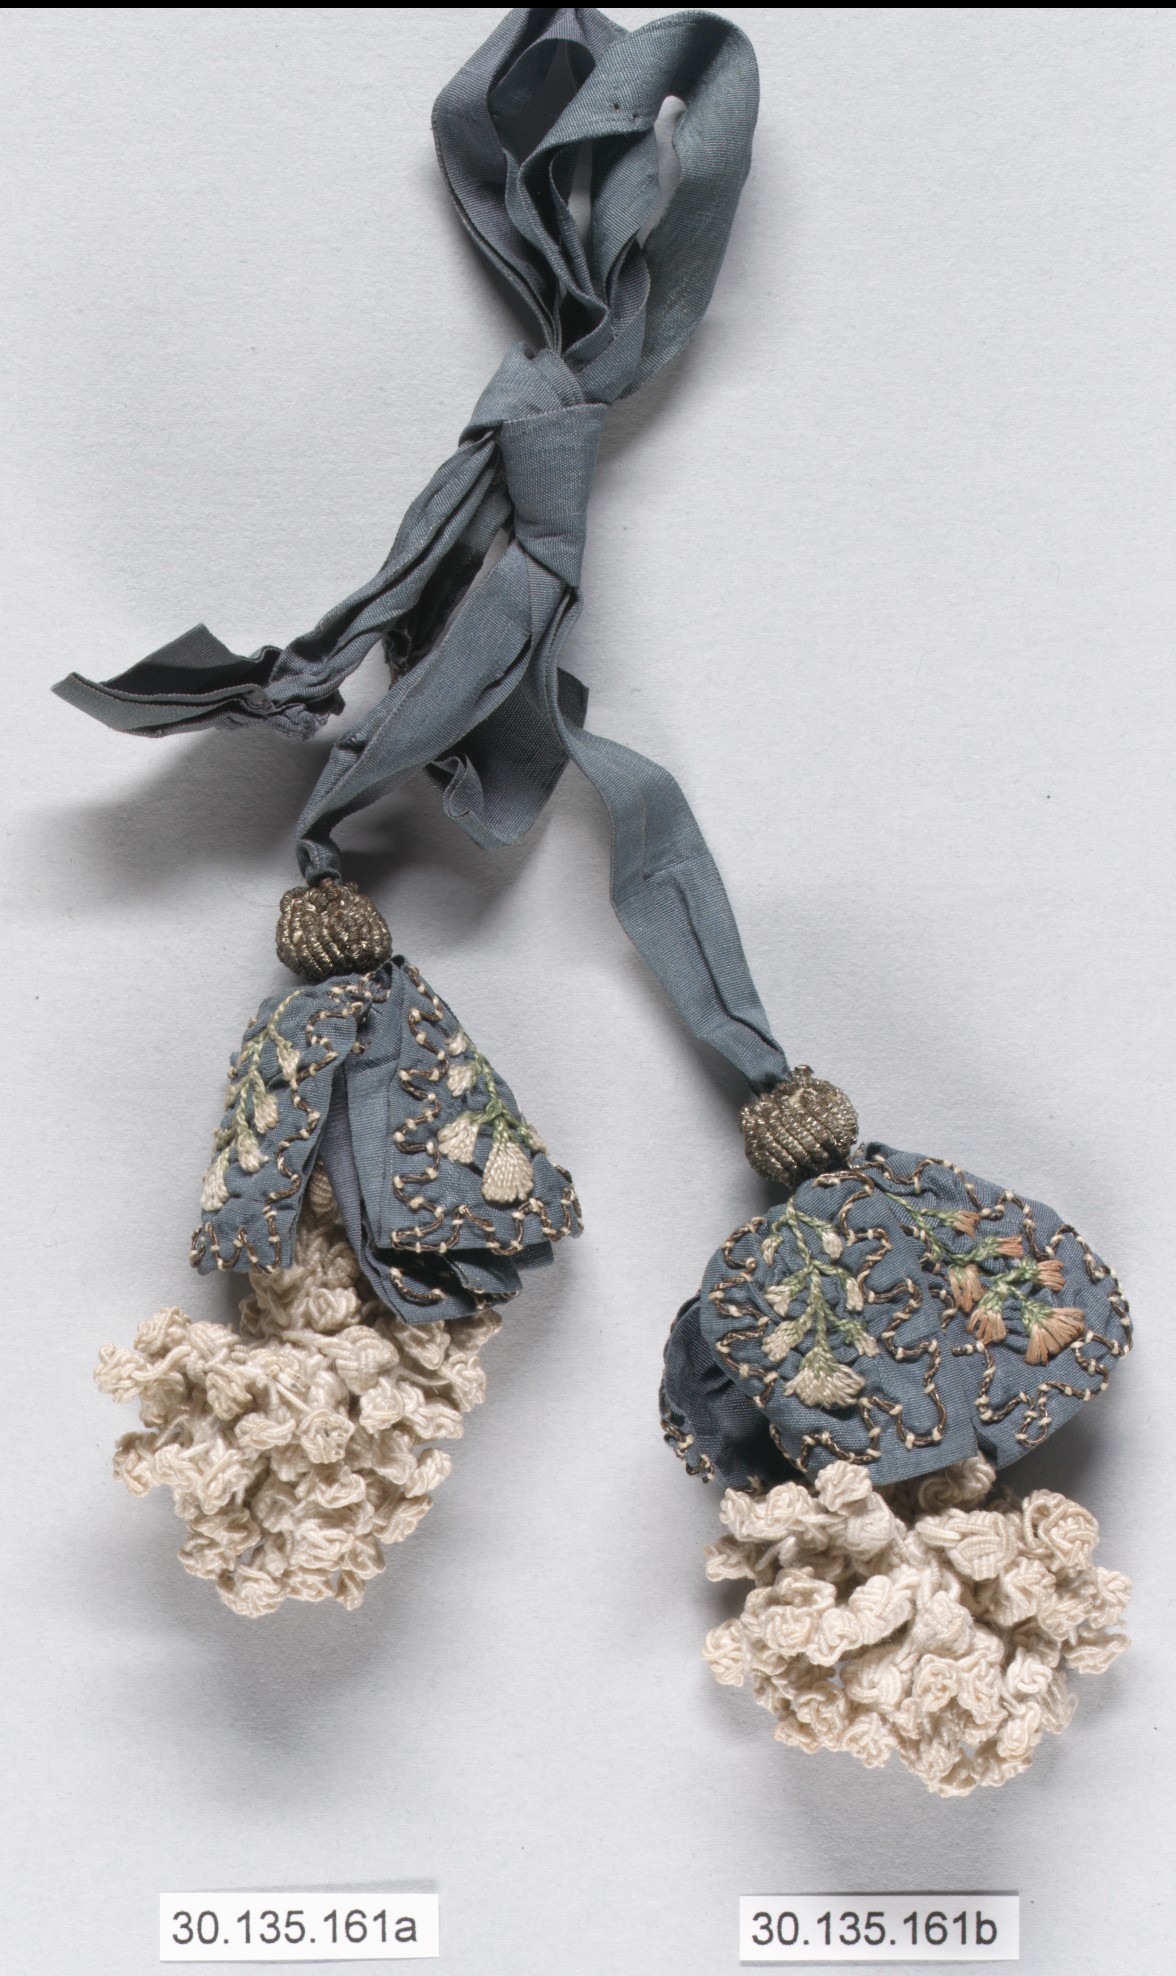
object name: tassel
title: Pair of tassels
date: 1601-1700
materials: linen, silk